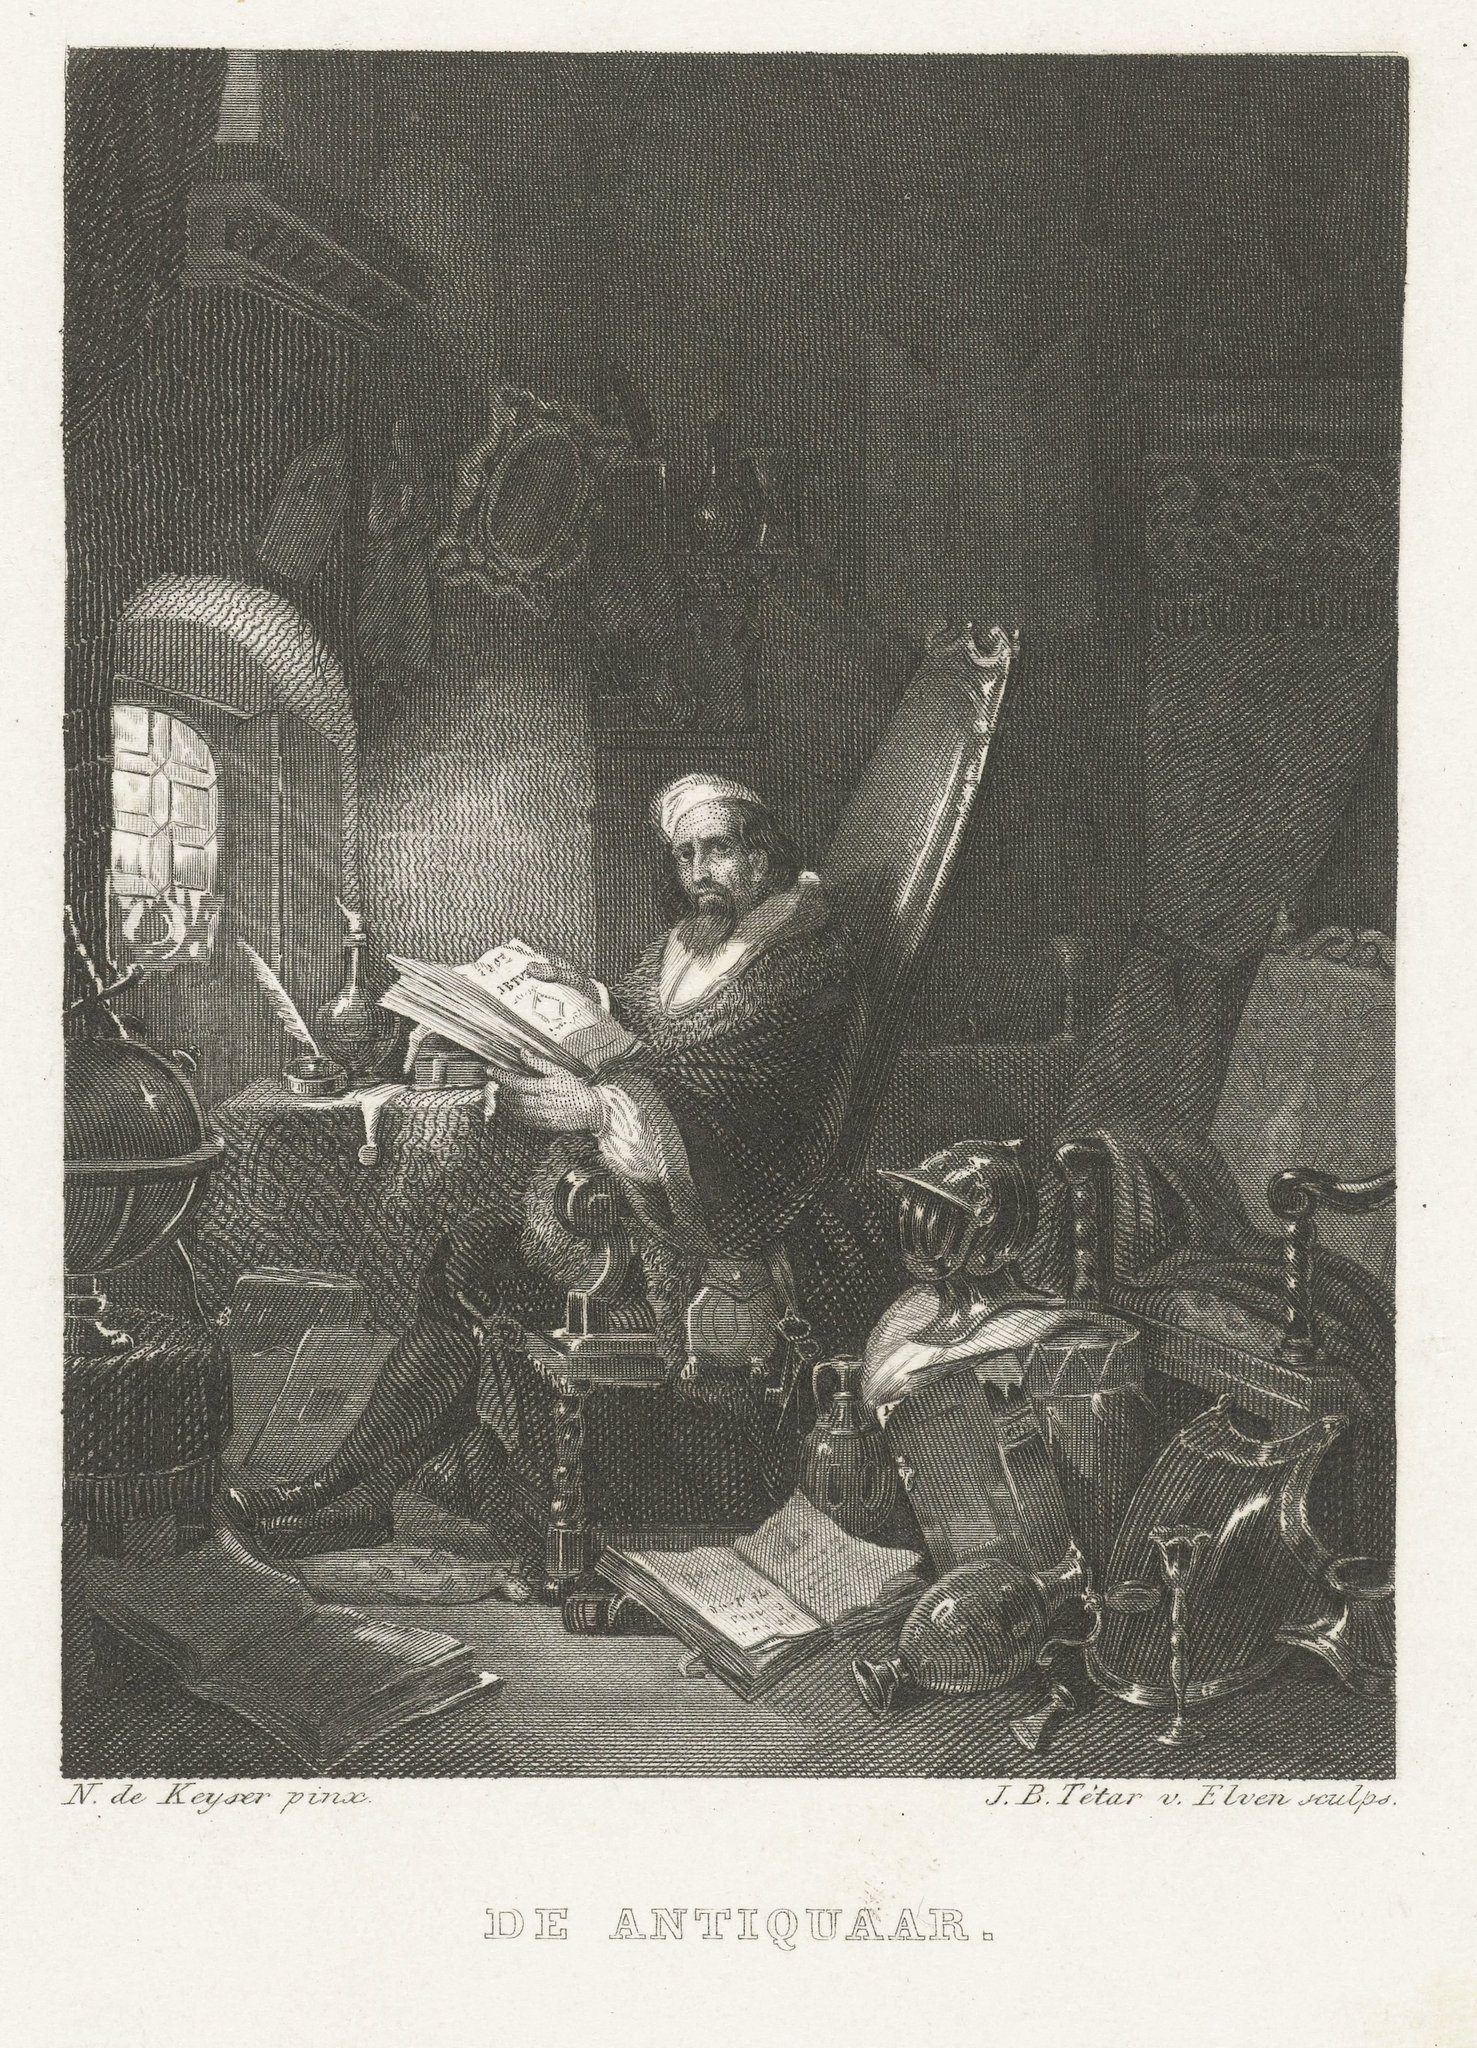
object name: print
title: Het antiquaar.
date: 1849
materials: paper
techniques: engraving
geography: antwerp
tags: antique dealer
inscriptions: inscription: ‘Alm. v. h. Schoone en Goede. 1849’, collector's mark: Lugt 2228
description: Een man met een boek in de handen zit in een stoel met een hoge rugleuning. Om hem heen liggen curiositeiten waaronder een harnas, schild en globe. De prent is gemaakt voor de Nederlandstalige Almanak Voor het Schoone en Goede.